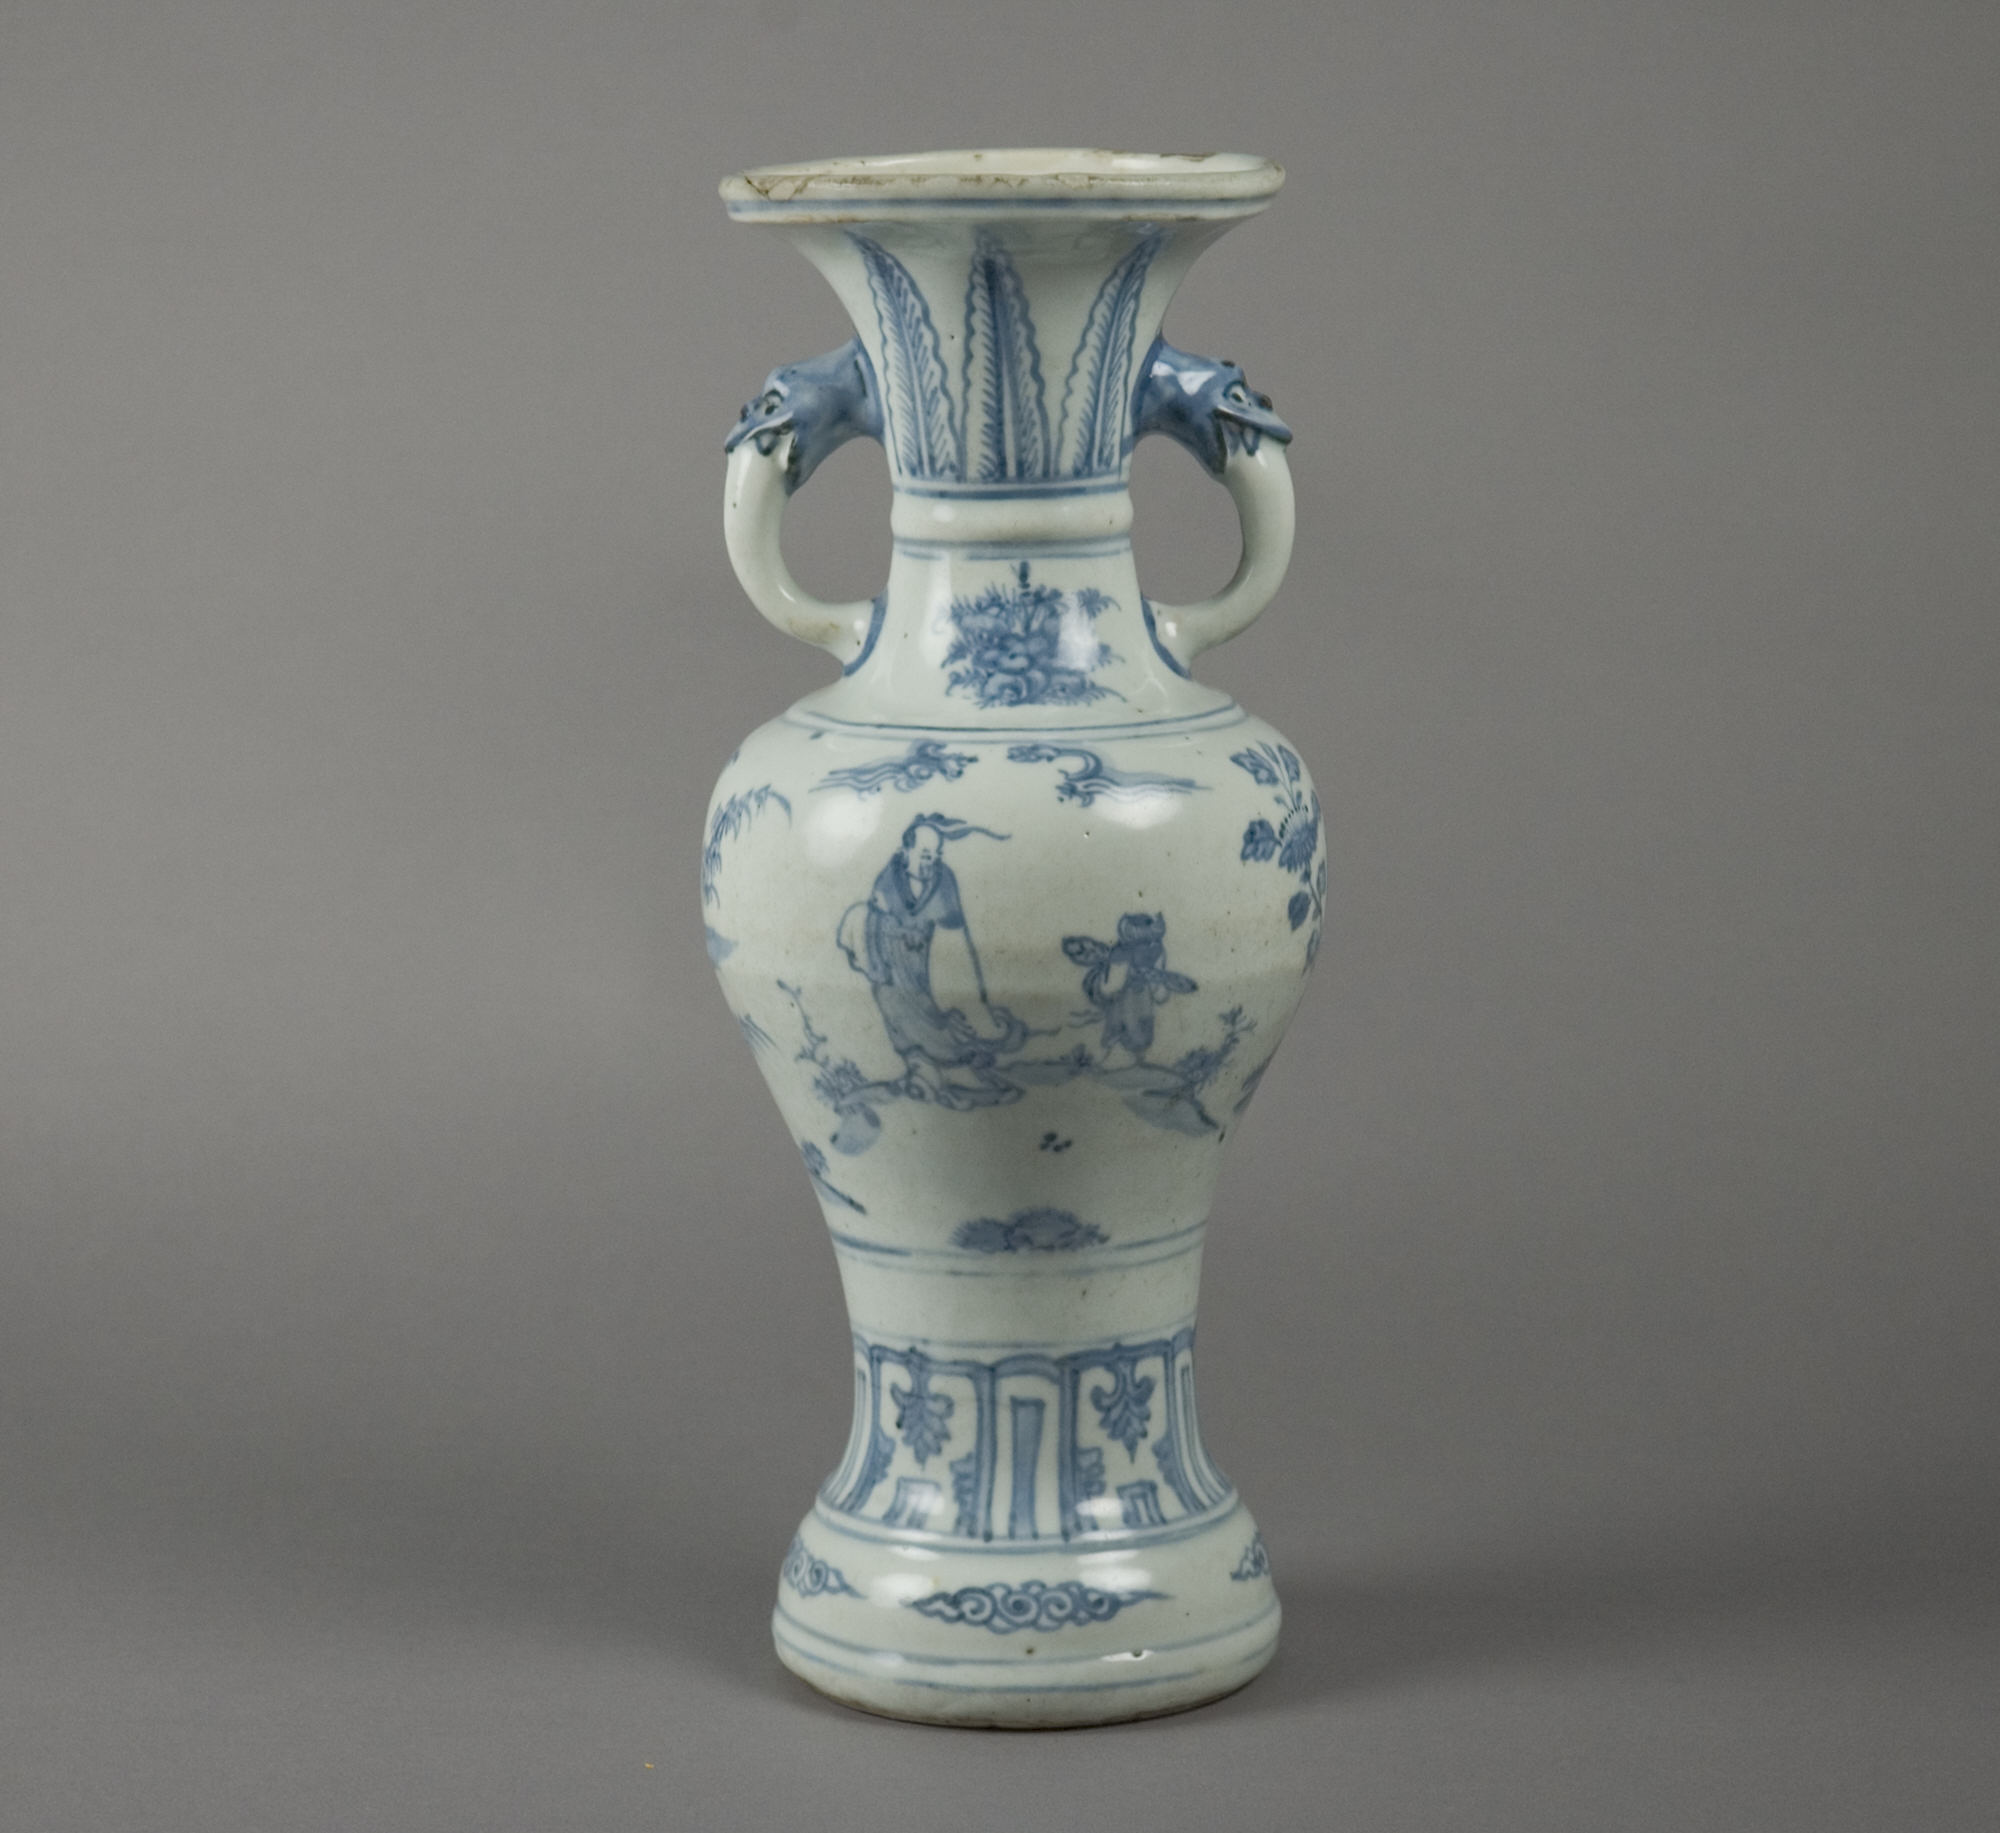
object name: vase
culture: chinese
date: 1500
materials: porcelain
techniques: painting, underglaze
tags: men,flowers,leaves